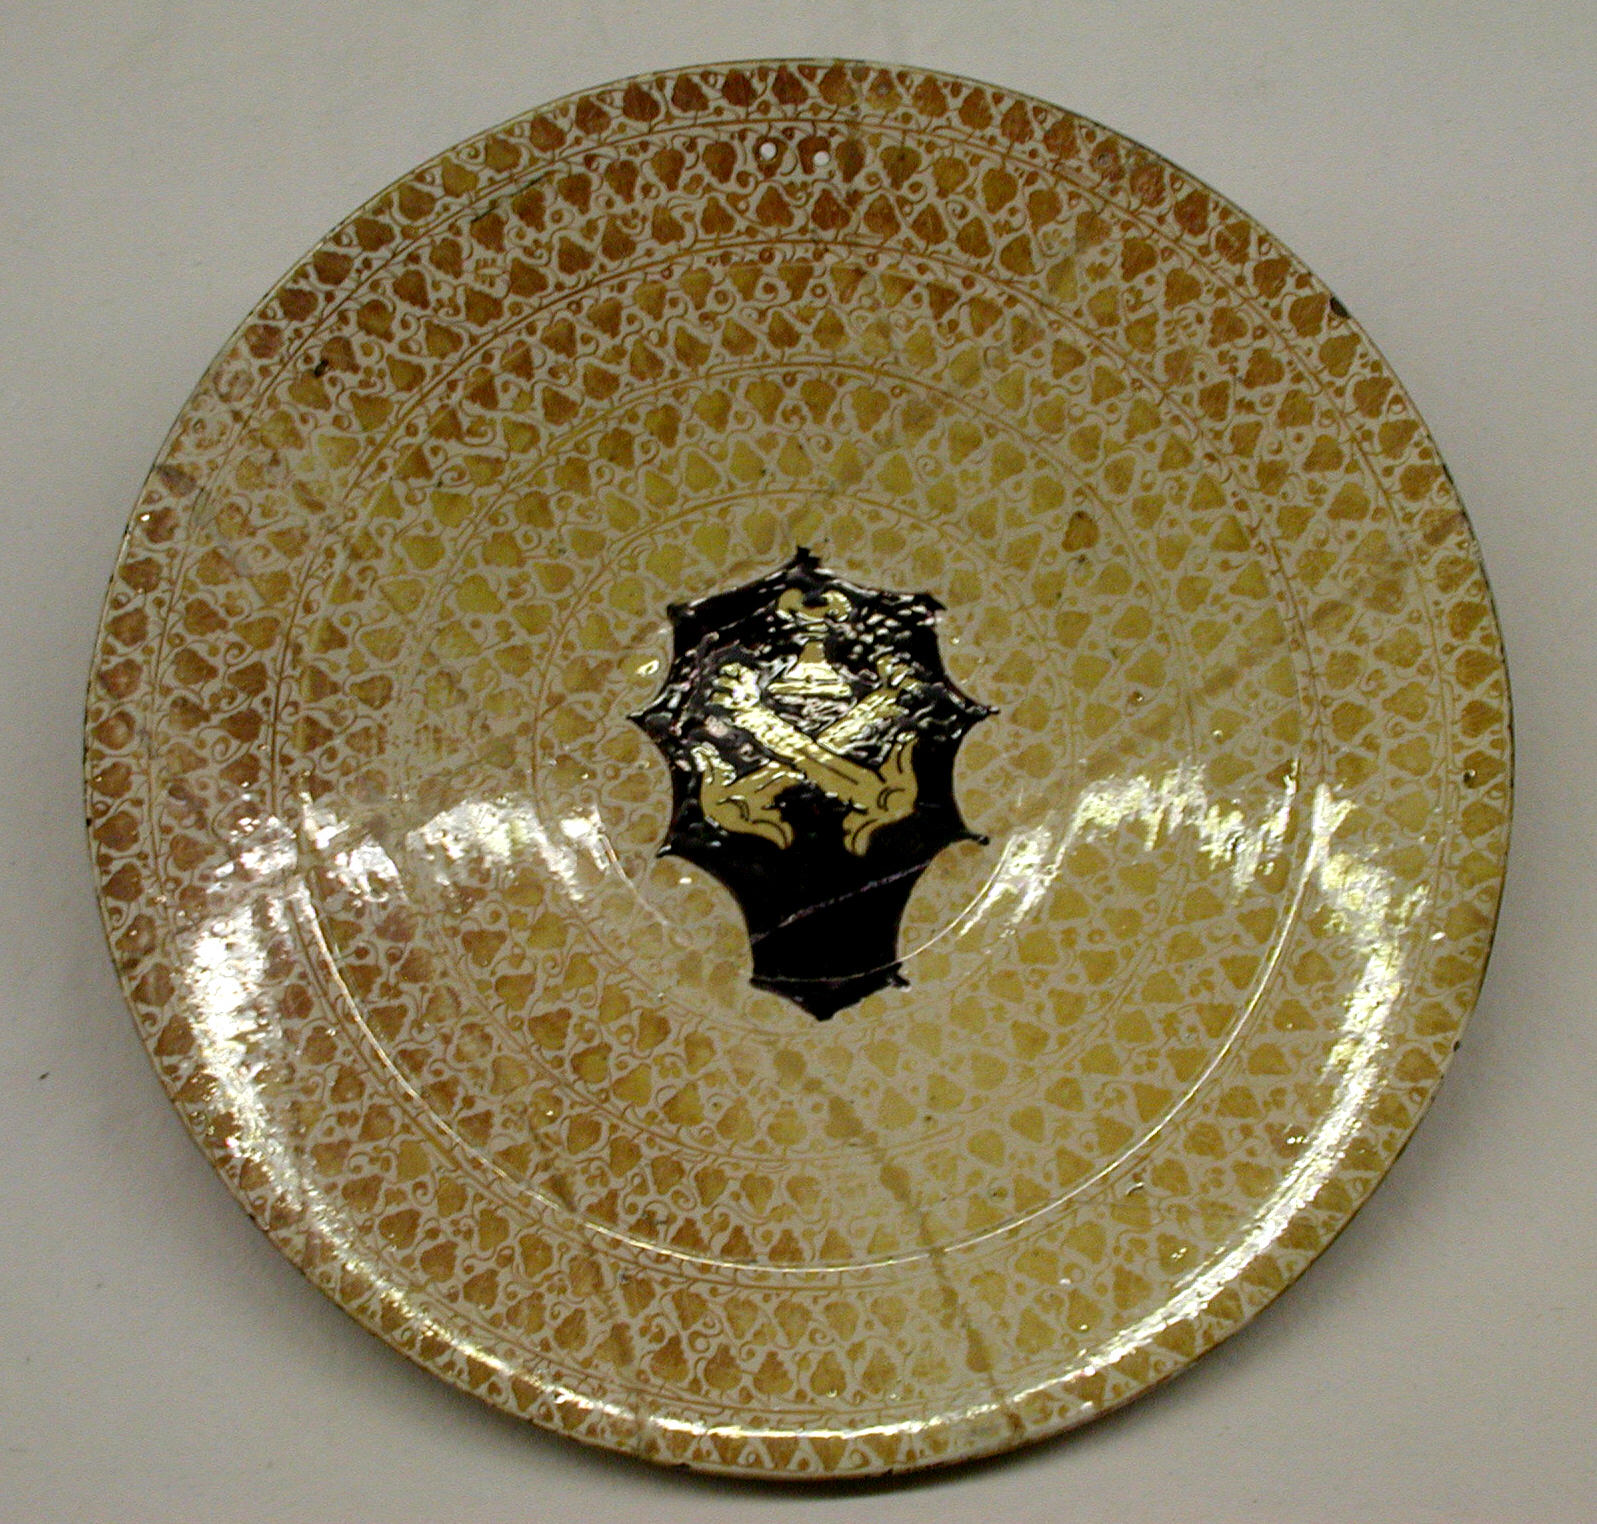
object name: dish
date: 1450-1475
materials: earthenware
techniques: luster painting, glazing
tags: coat of arms